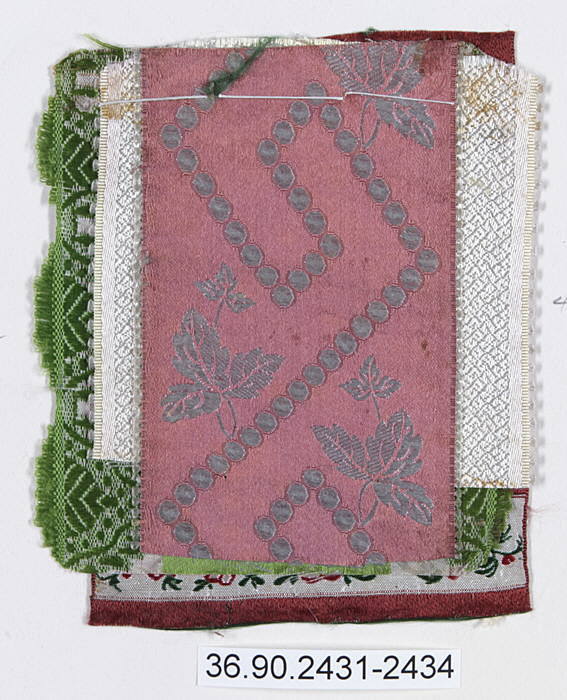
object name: ribbon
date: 1801-1900